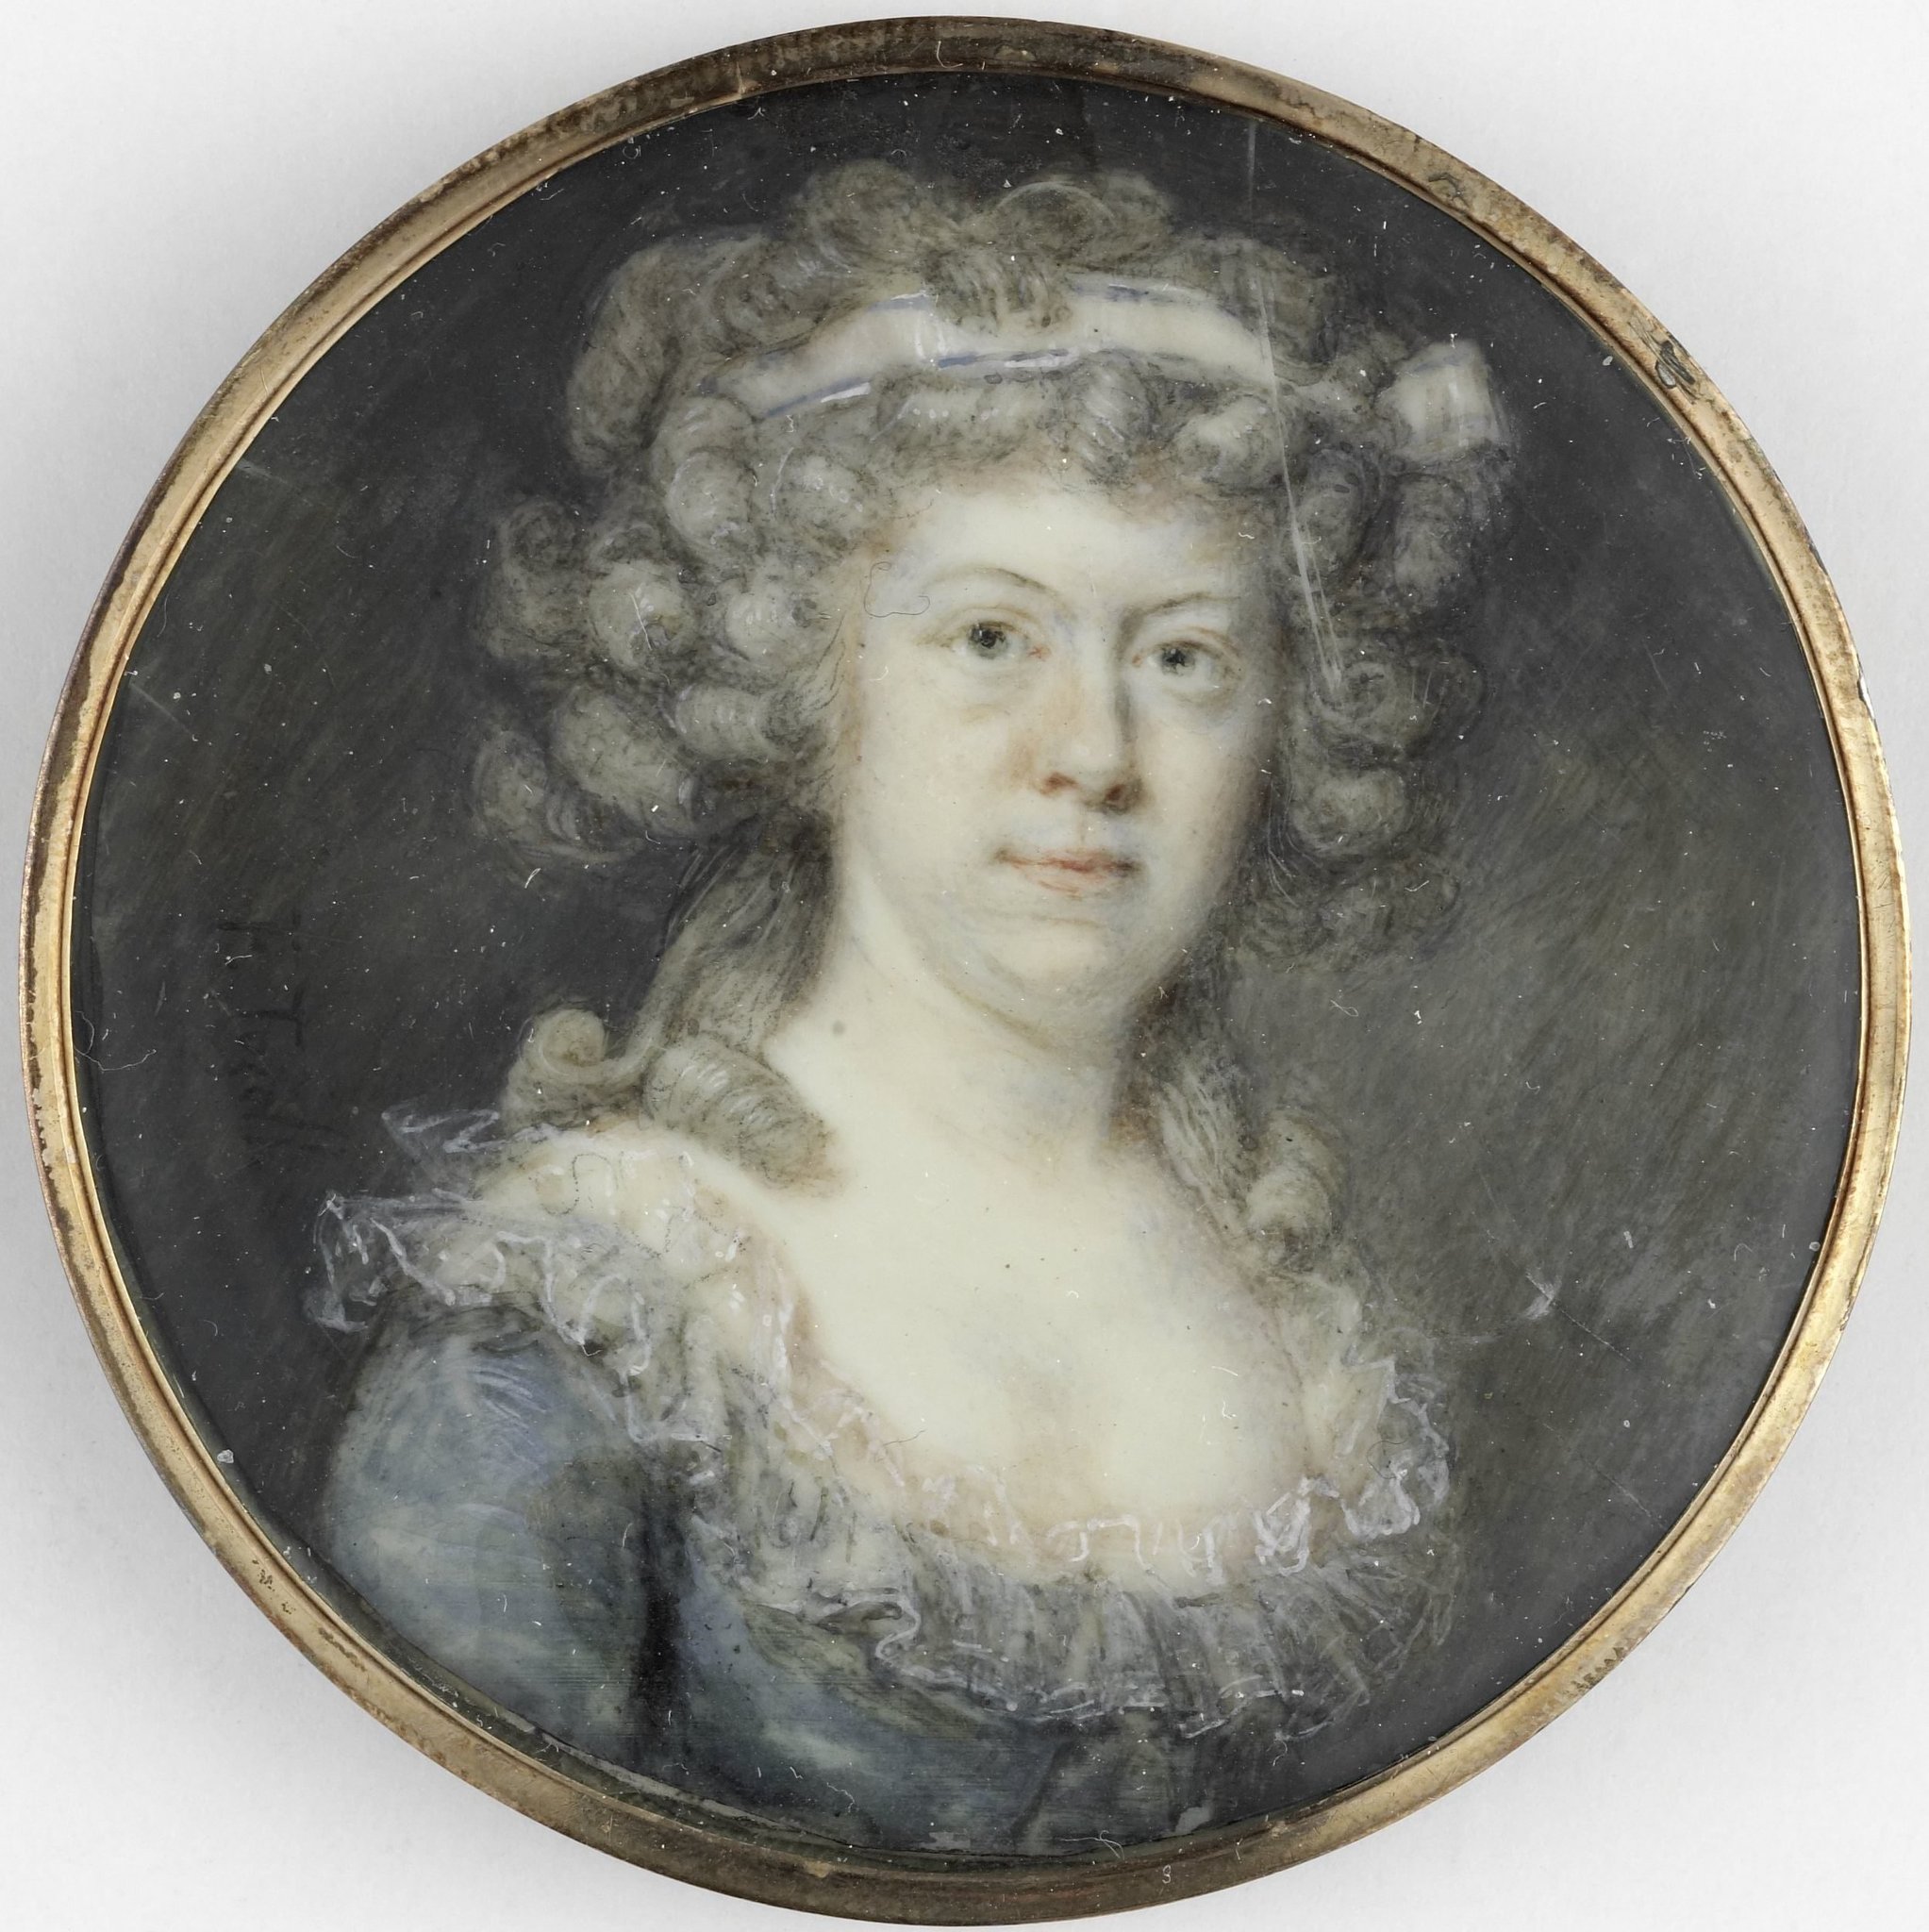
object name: painting, miniature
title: Portret van een vrouw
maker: francesco tozelli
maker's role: pastelschilder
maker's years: 1745-1822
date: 1790-1800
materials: glass, ivory, metal, textile, watercolor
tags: historical persons not known by name - bb - woman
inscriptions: signature: ‘F. Tozelli’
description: Francesco Tozelli (1749 - after 1808). Portrait of a woman. Ivory, in a narrow frame of gilded metal and originally probably mounted on the lid of a round box, c. 1790.